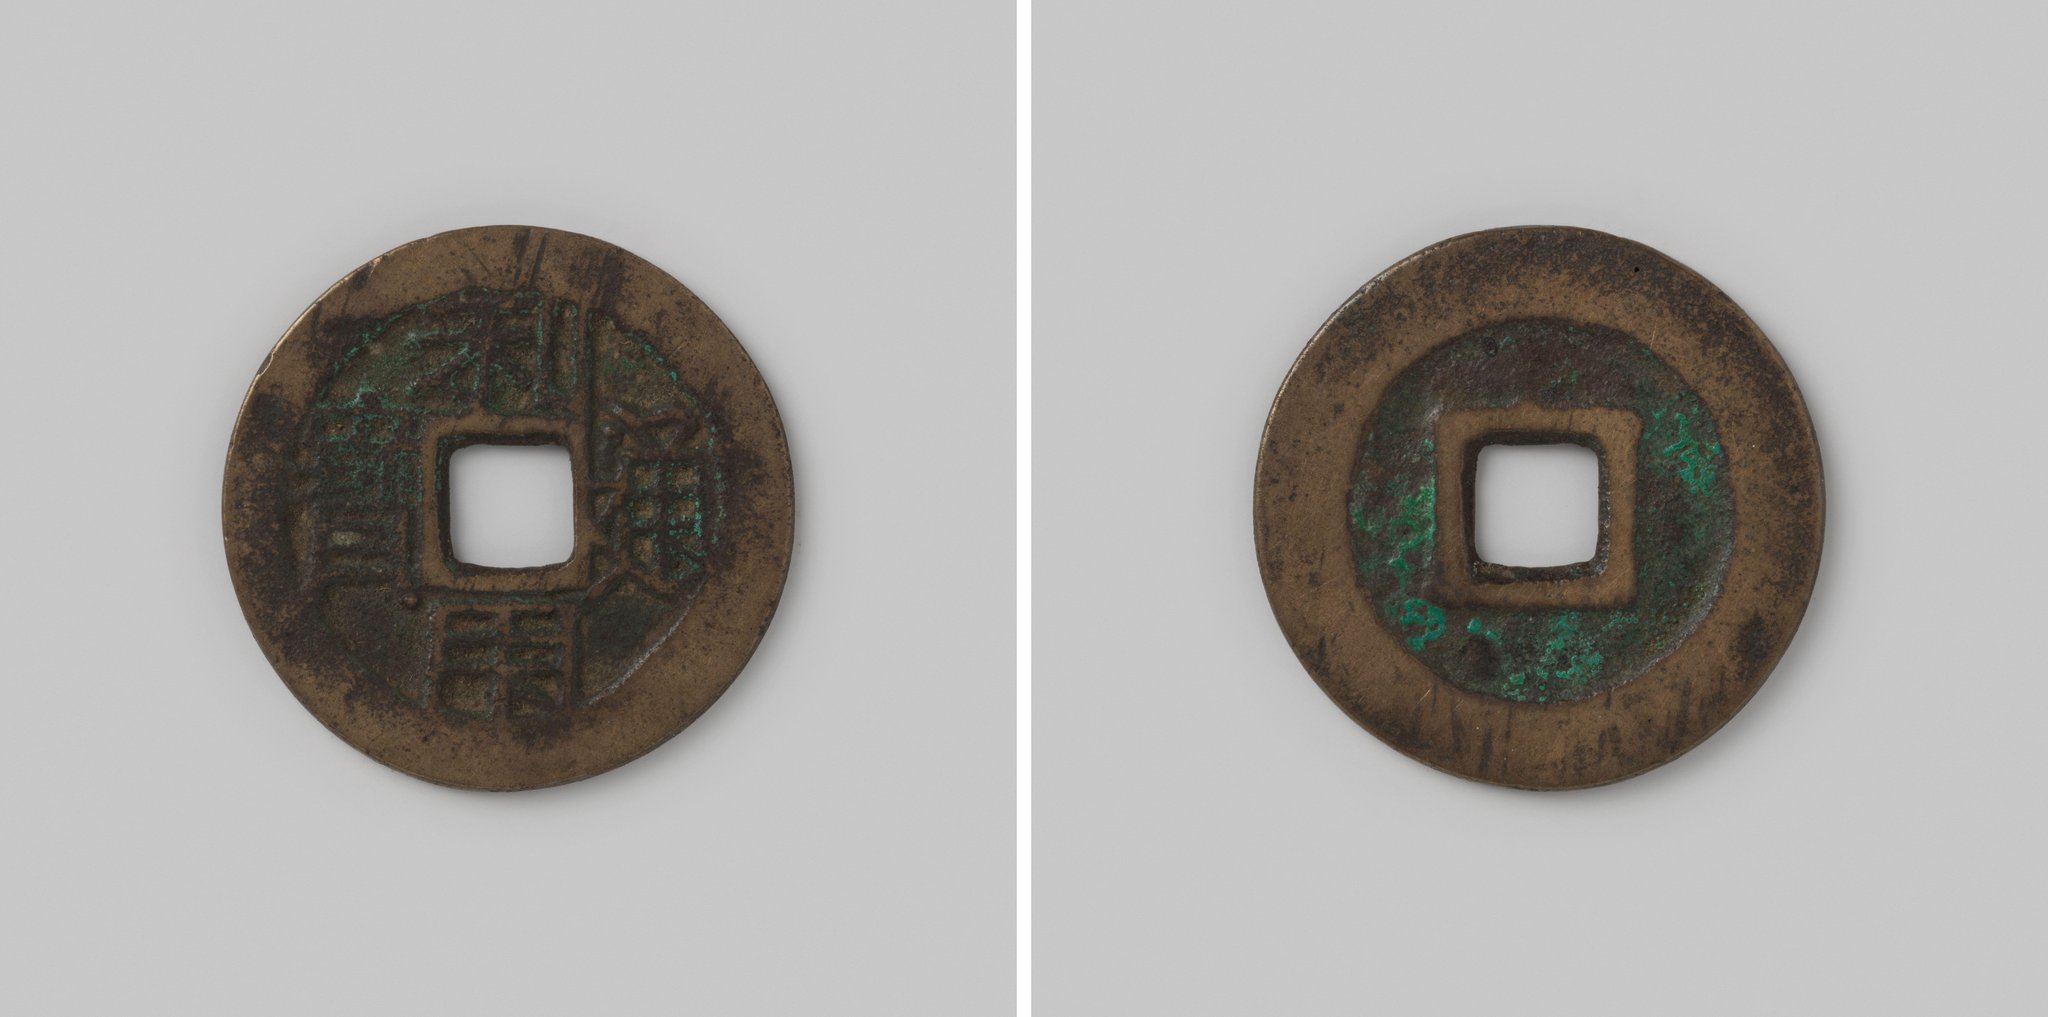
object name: coin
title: Cash van China van de opstandeling Wu San Kuiei onder de regeringsnaam Li-Yung, 1673 -1674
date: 1673-1674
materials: copper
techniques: casting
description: Koperen munt. Voorzijde: binnen brede opstaande rand rondom vierkante uitsparing in het midden vier kruisgewijze geplaatste Chinese tekens. Keerzijde: binnen brede opstaande rand glad.